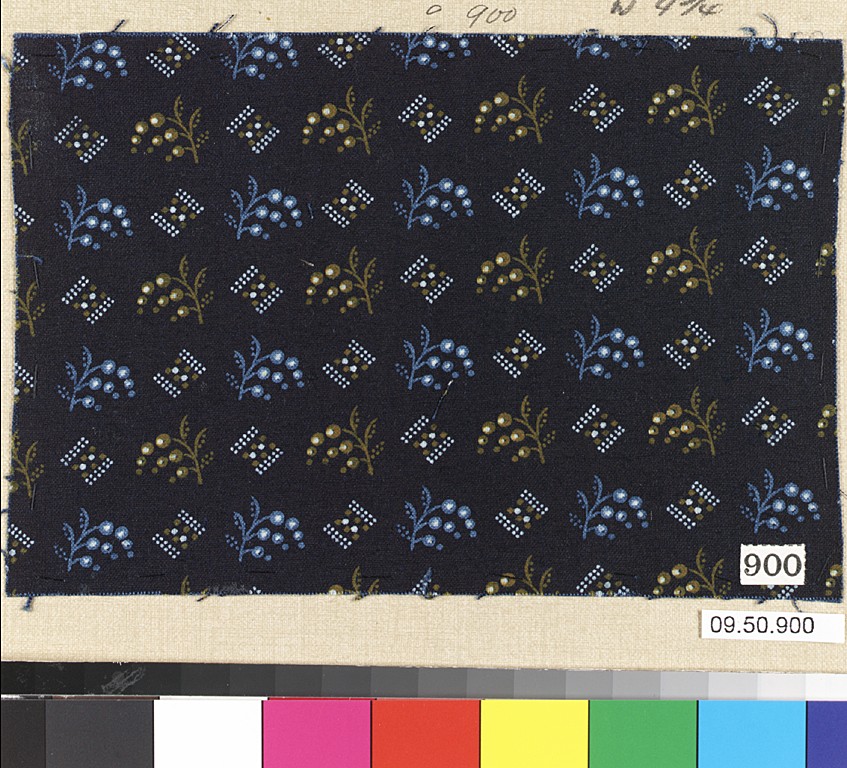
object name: piece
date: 1801-1900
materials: cotton